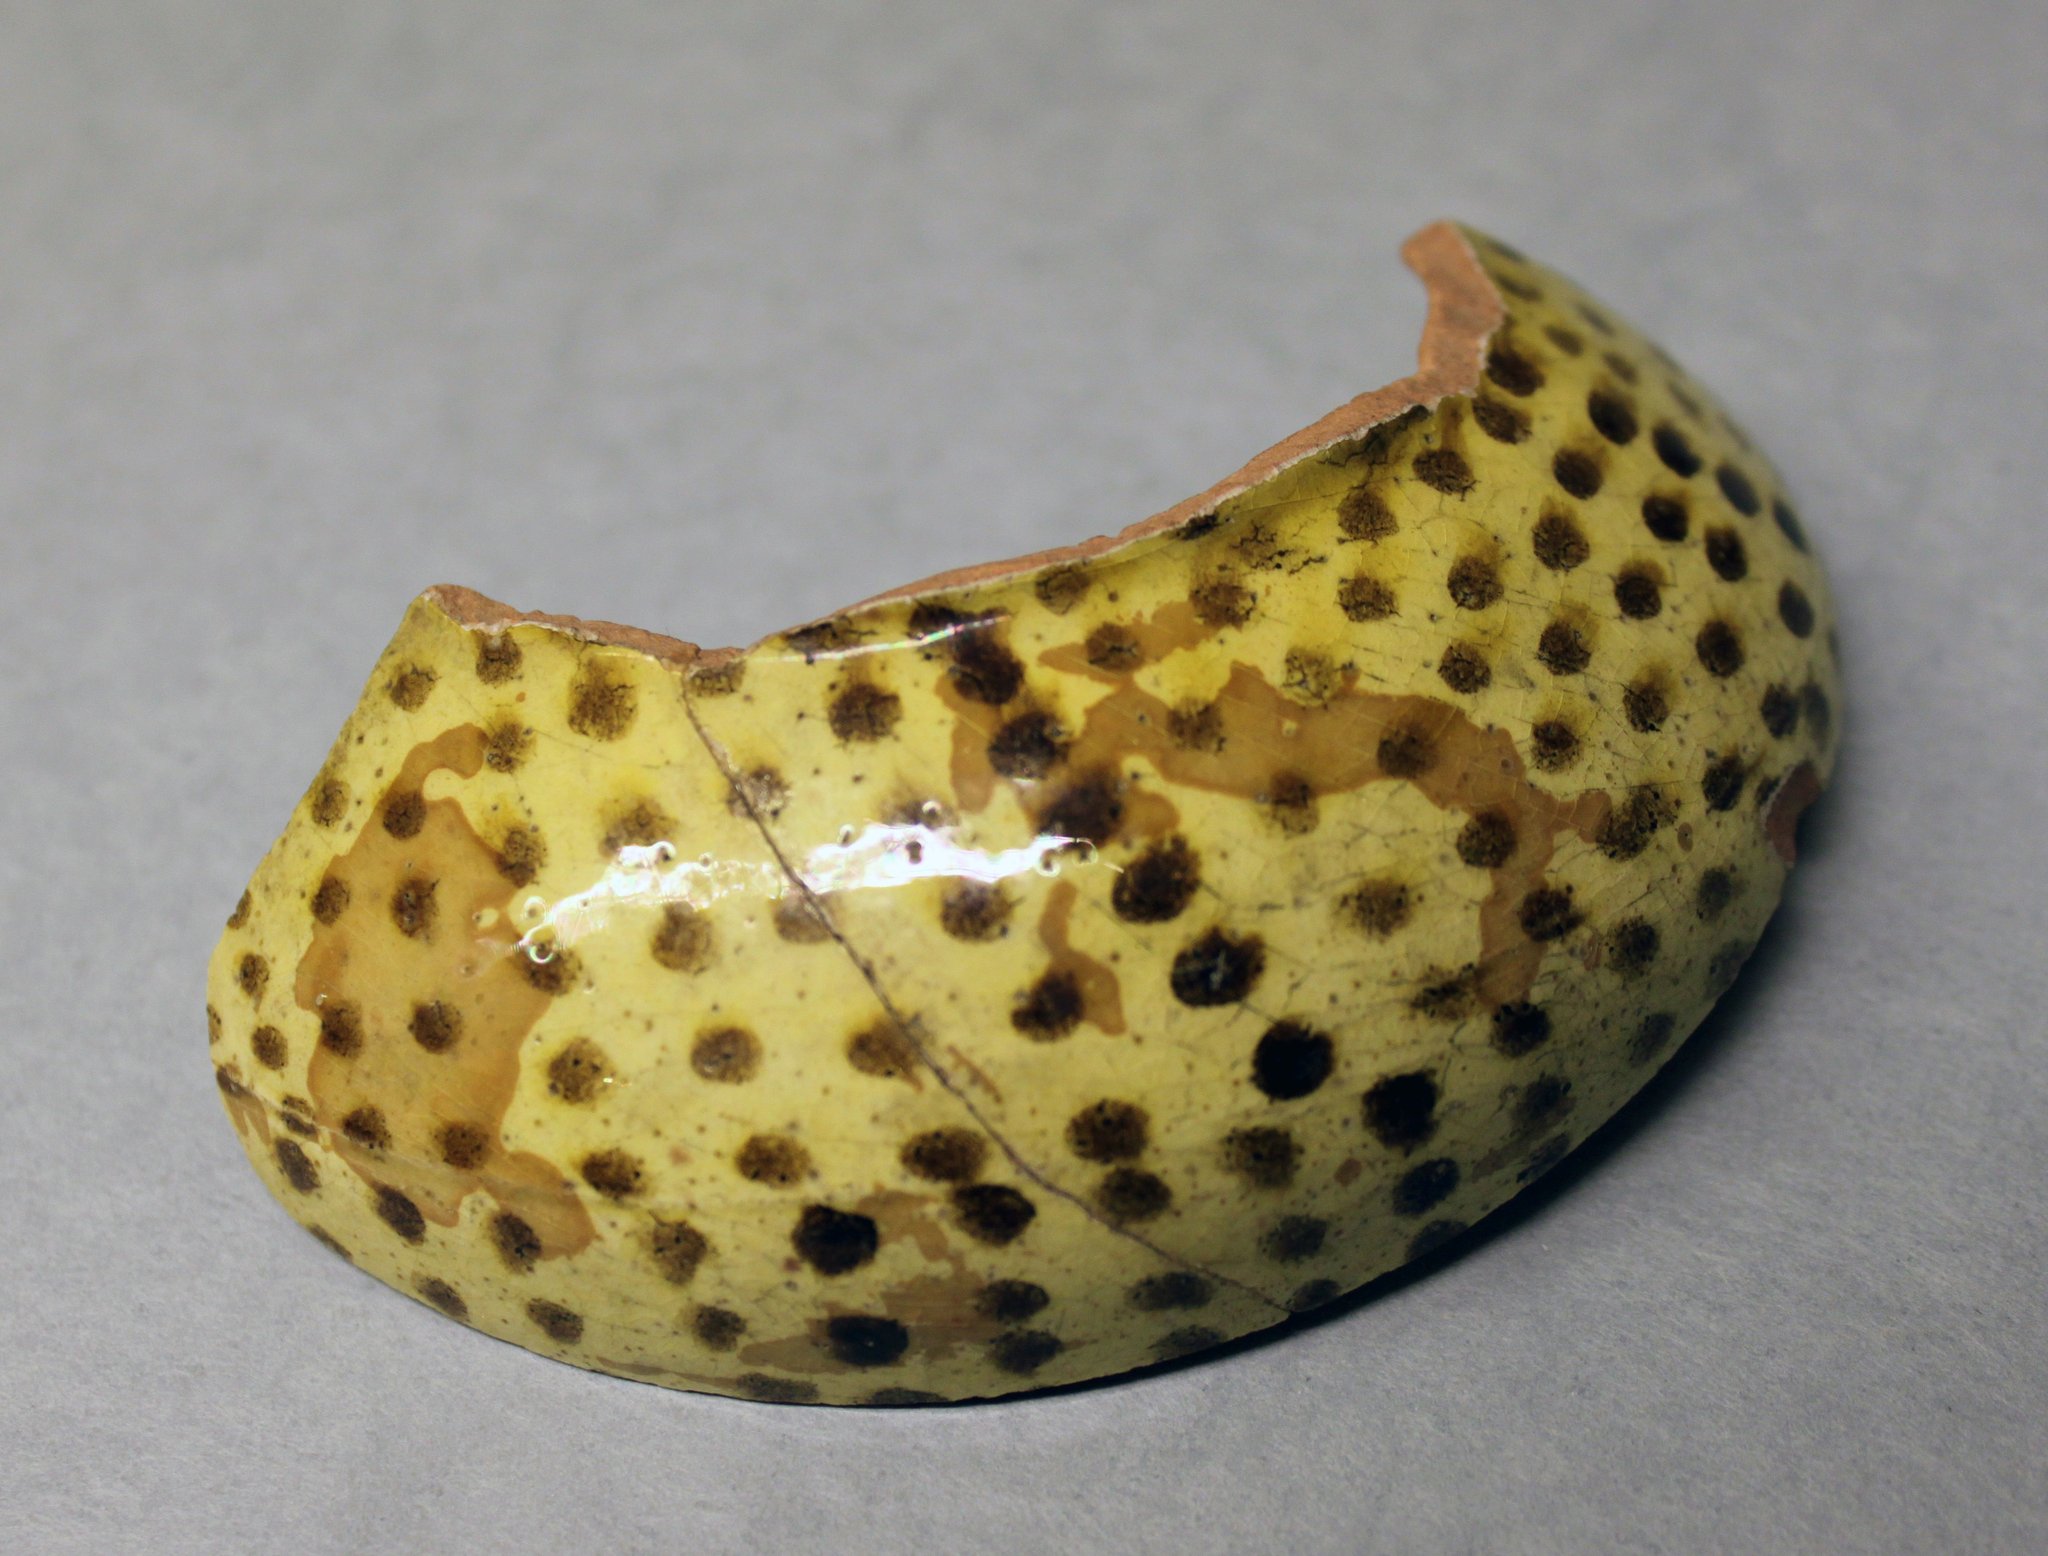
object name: fragment of a jar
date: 801-1000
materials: earthenware, glaze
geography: iran